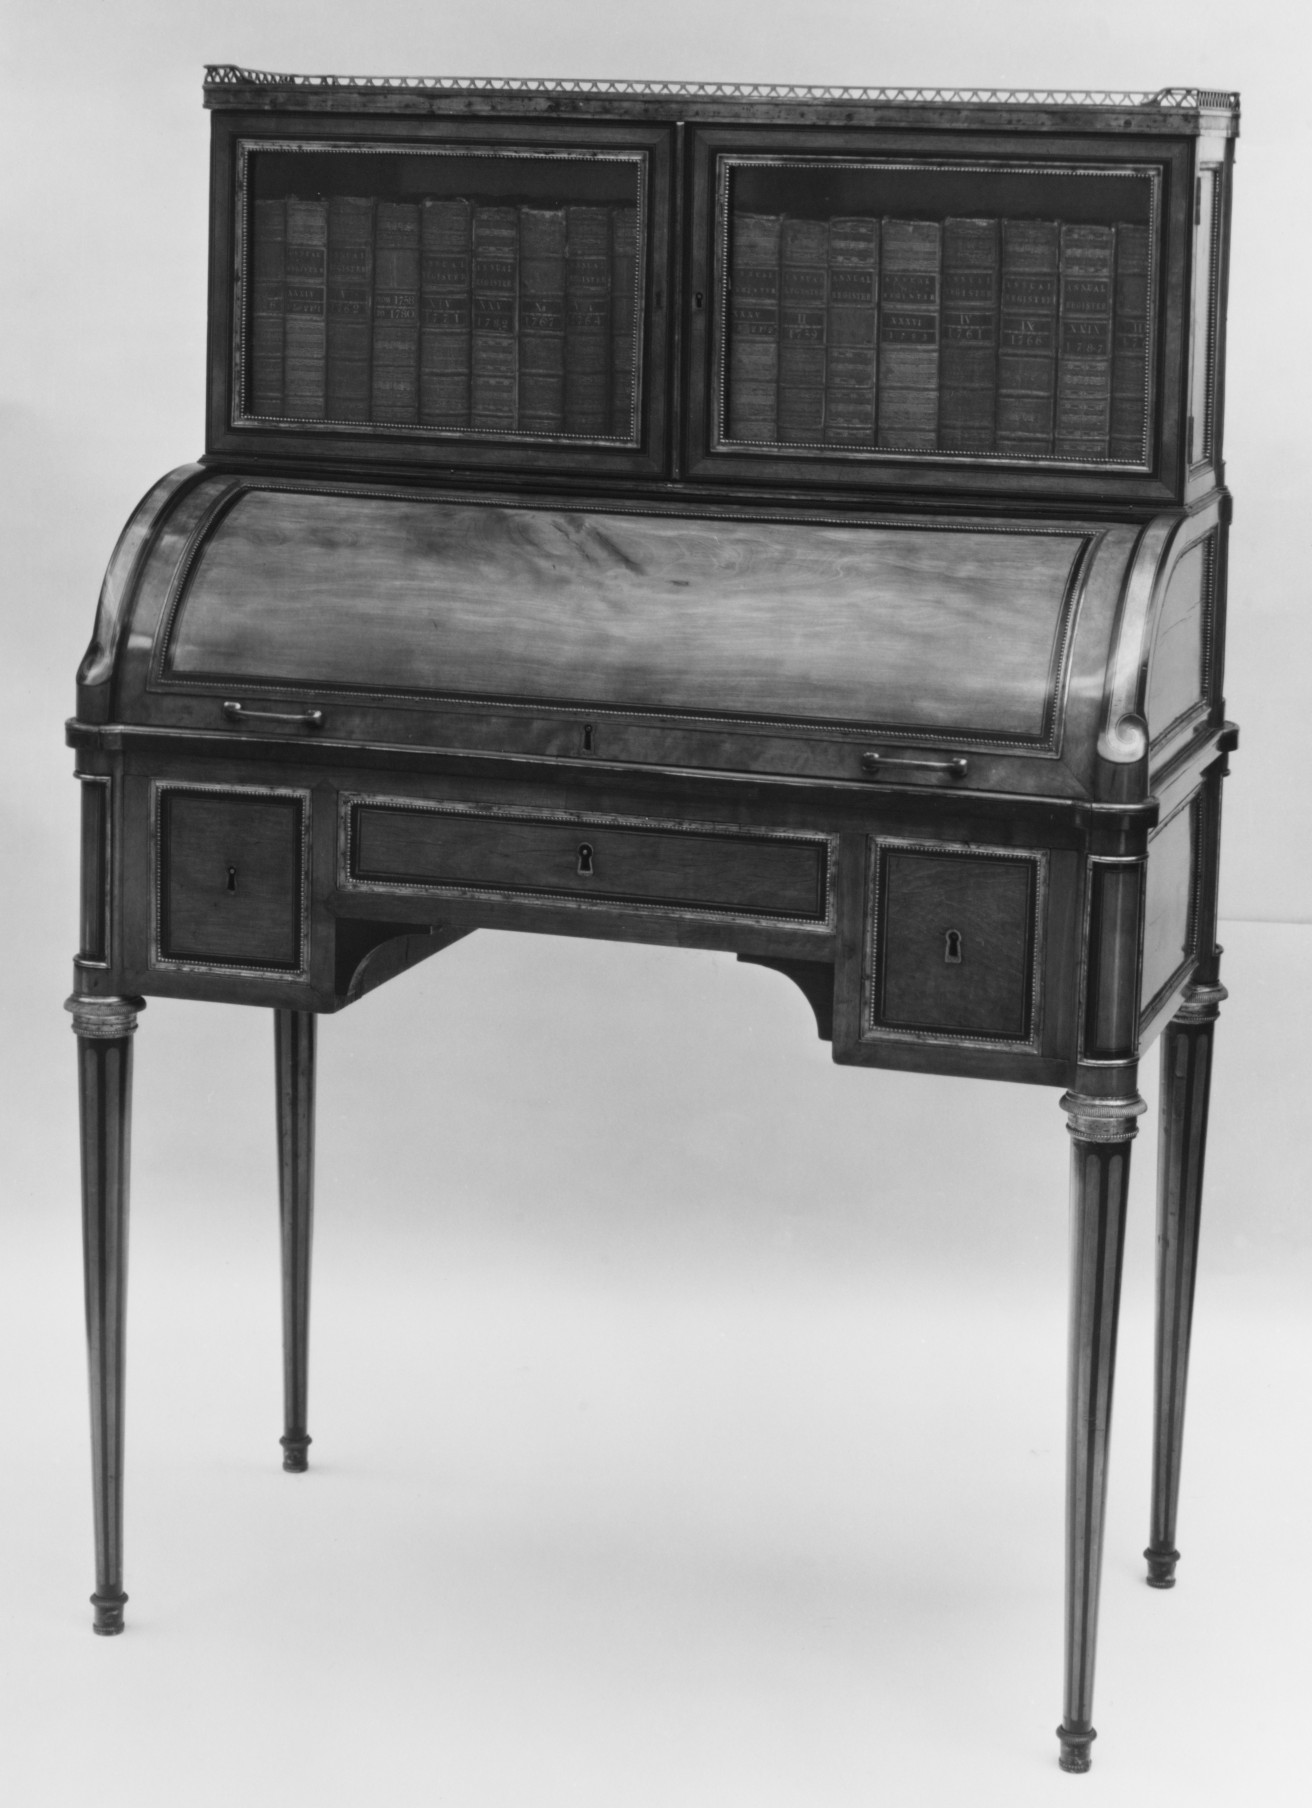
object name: cylinder fall desk with cabinet top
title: Cylinder-fall desk with cabinet top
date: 1790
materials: gilt bronze, marble, wood